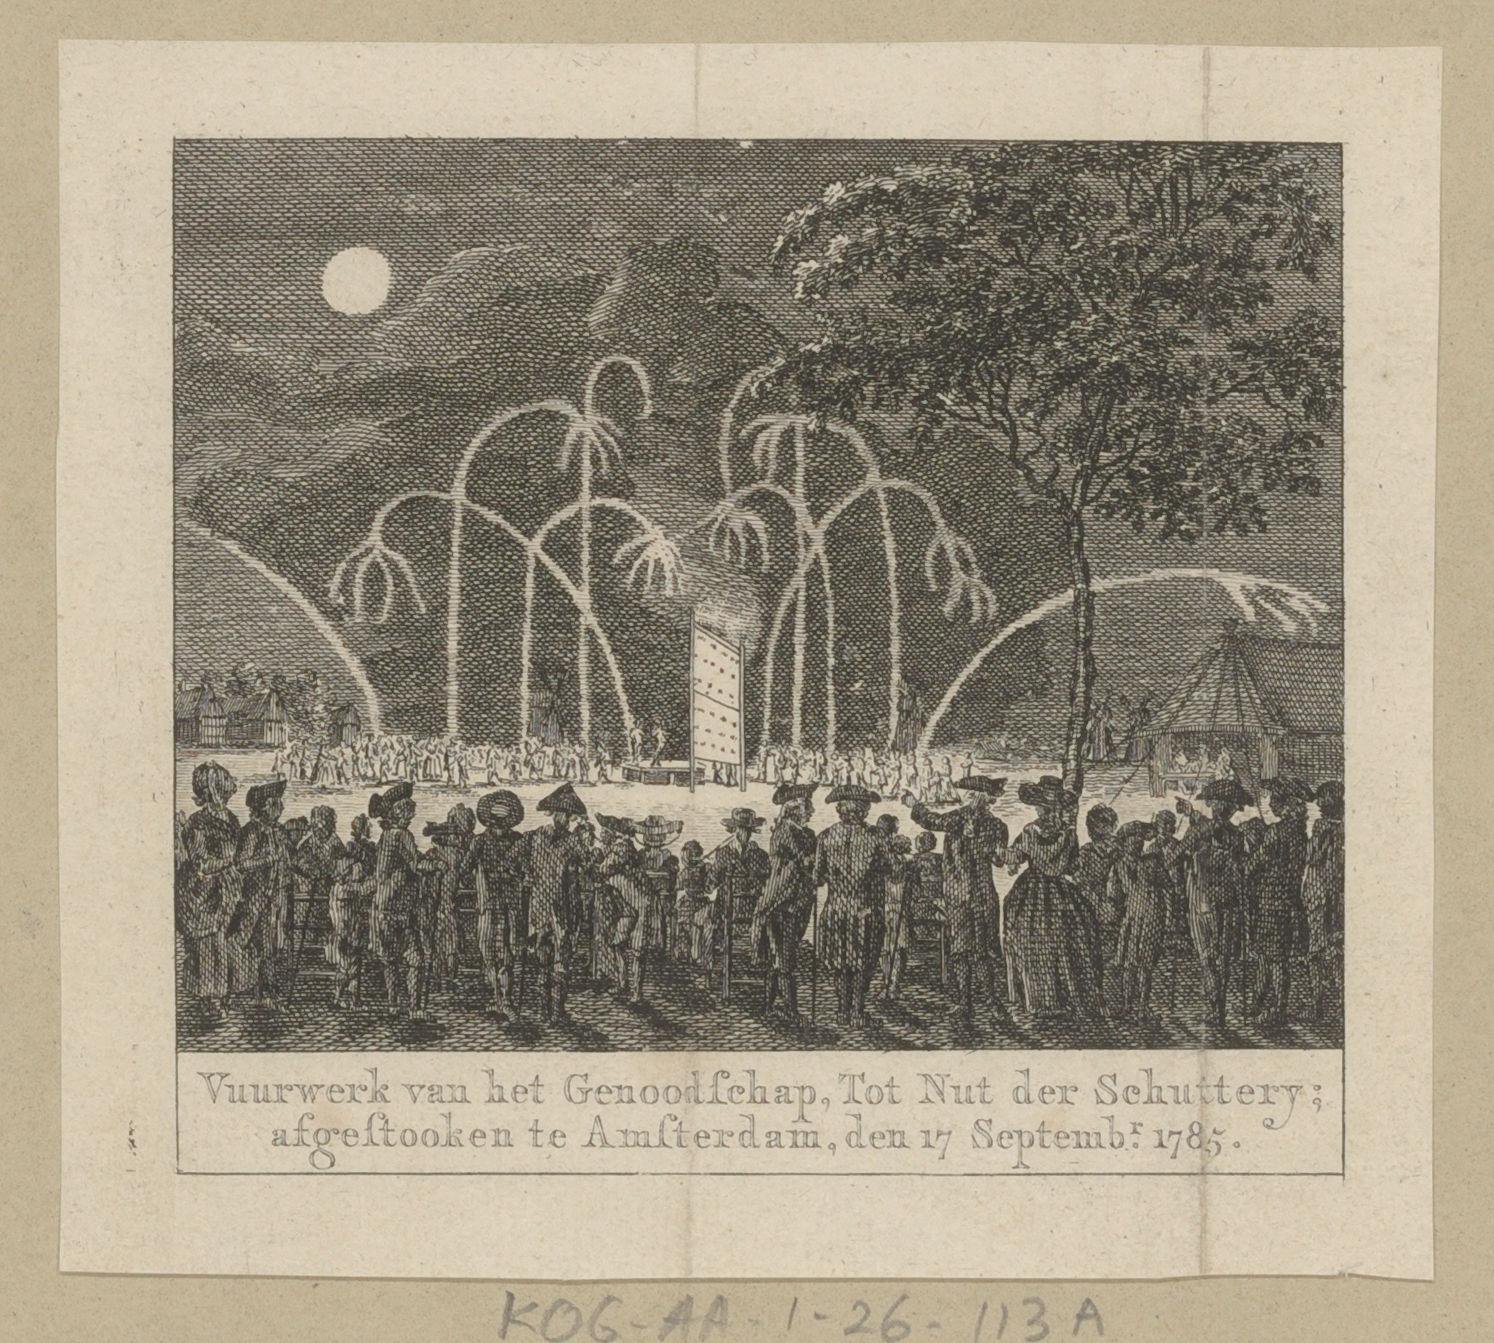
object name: book illustration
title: Vuurwerk van het Genoodschap, Tot Nut der Schuttery; afgestooken te Amsterdam, den 17 Septembr. 1785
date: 1801-1816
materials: paper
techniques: engraving, etching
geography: amsterdam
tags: crowd, mob, bonfire, fire-works, amsterdam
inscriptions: collector's mark: Lugt 1641b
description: Prent mogelijk uit: Fokke Simonsz., Arend. De vaderlandsche historie in themata (...). Amsterdam: Anthony Bernard Saakes, 1801. Of uit latere editie van 1816.